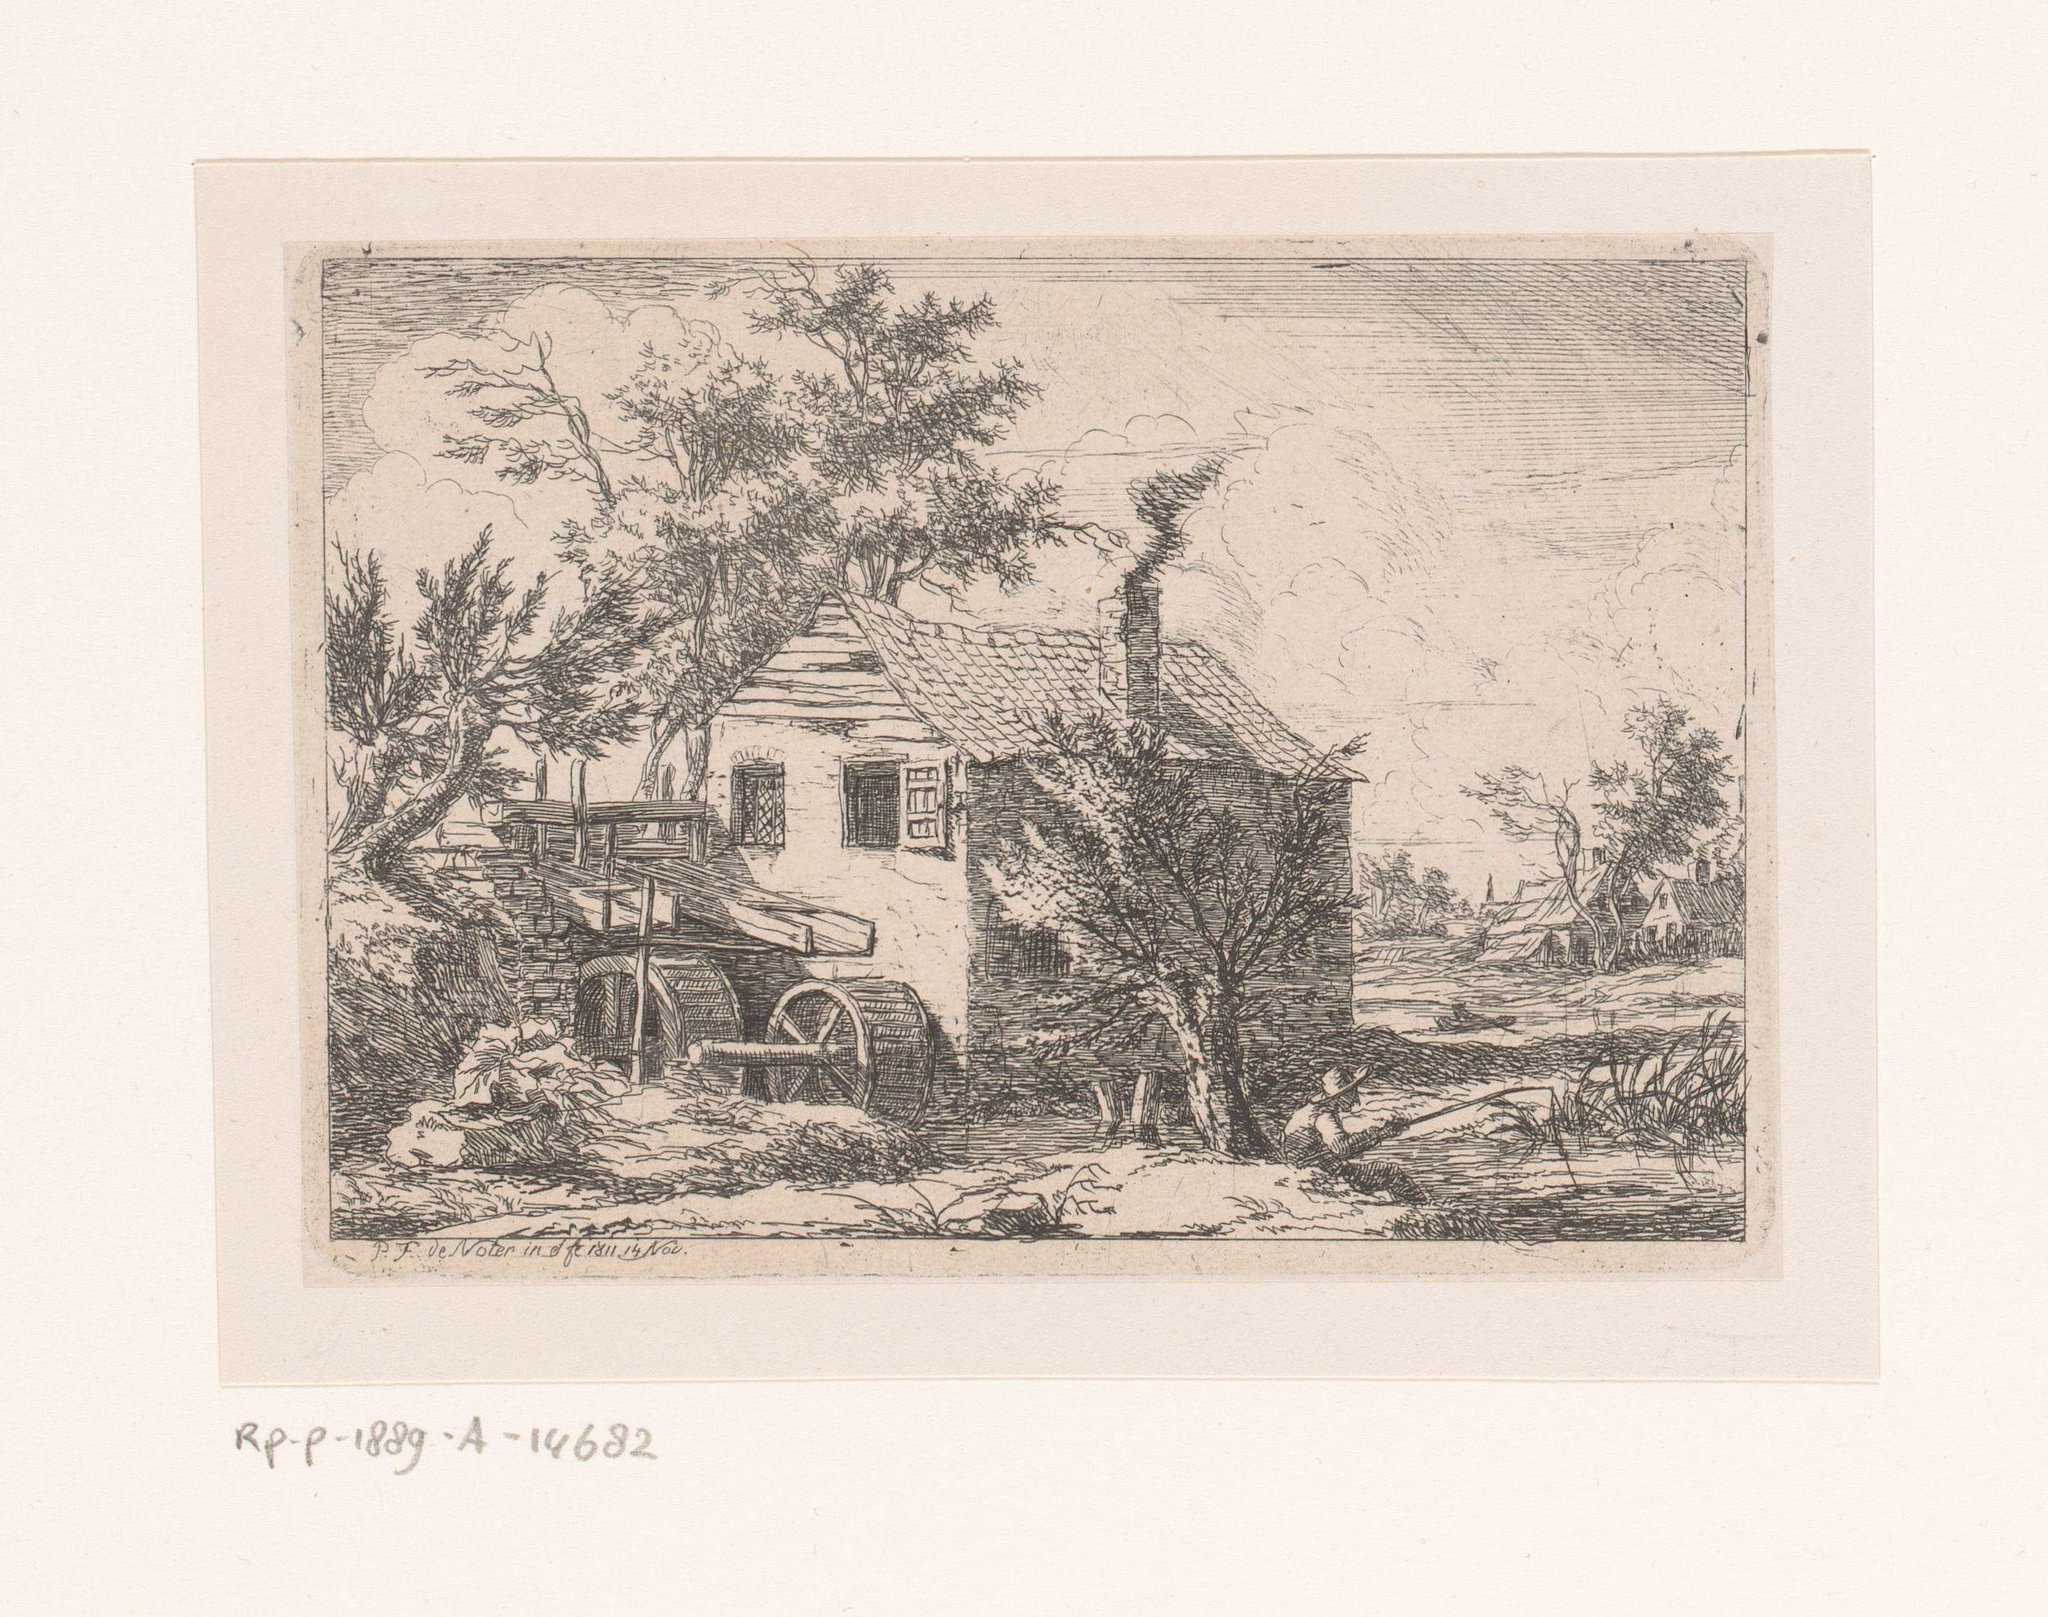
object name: print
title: Landschap met watermolen en een visser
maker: pierre françois de noter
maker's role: painter, print maker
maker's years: 1779-1843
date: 1811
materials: paper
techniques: etching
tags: watermill in landscape (+ city(-scape) with figures, staffage), angling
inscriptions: collector's mark: Lugt 2228